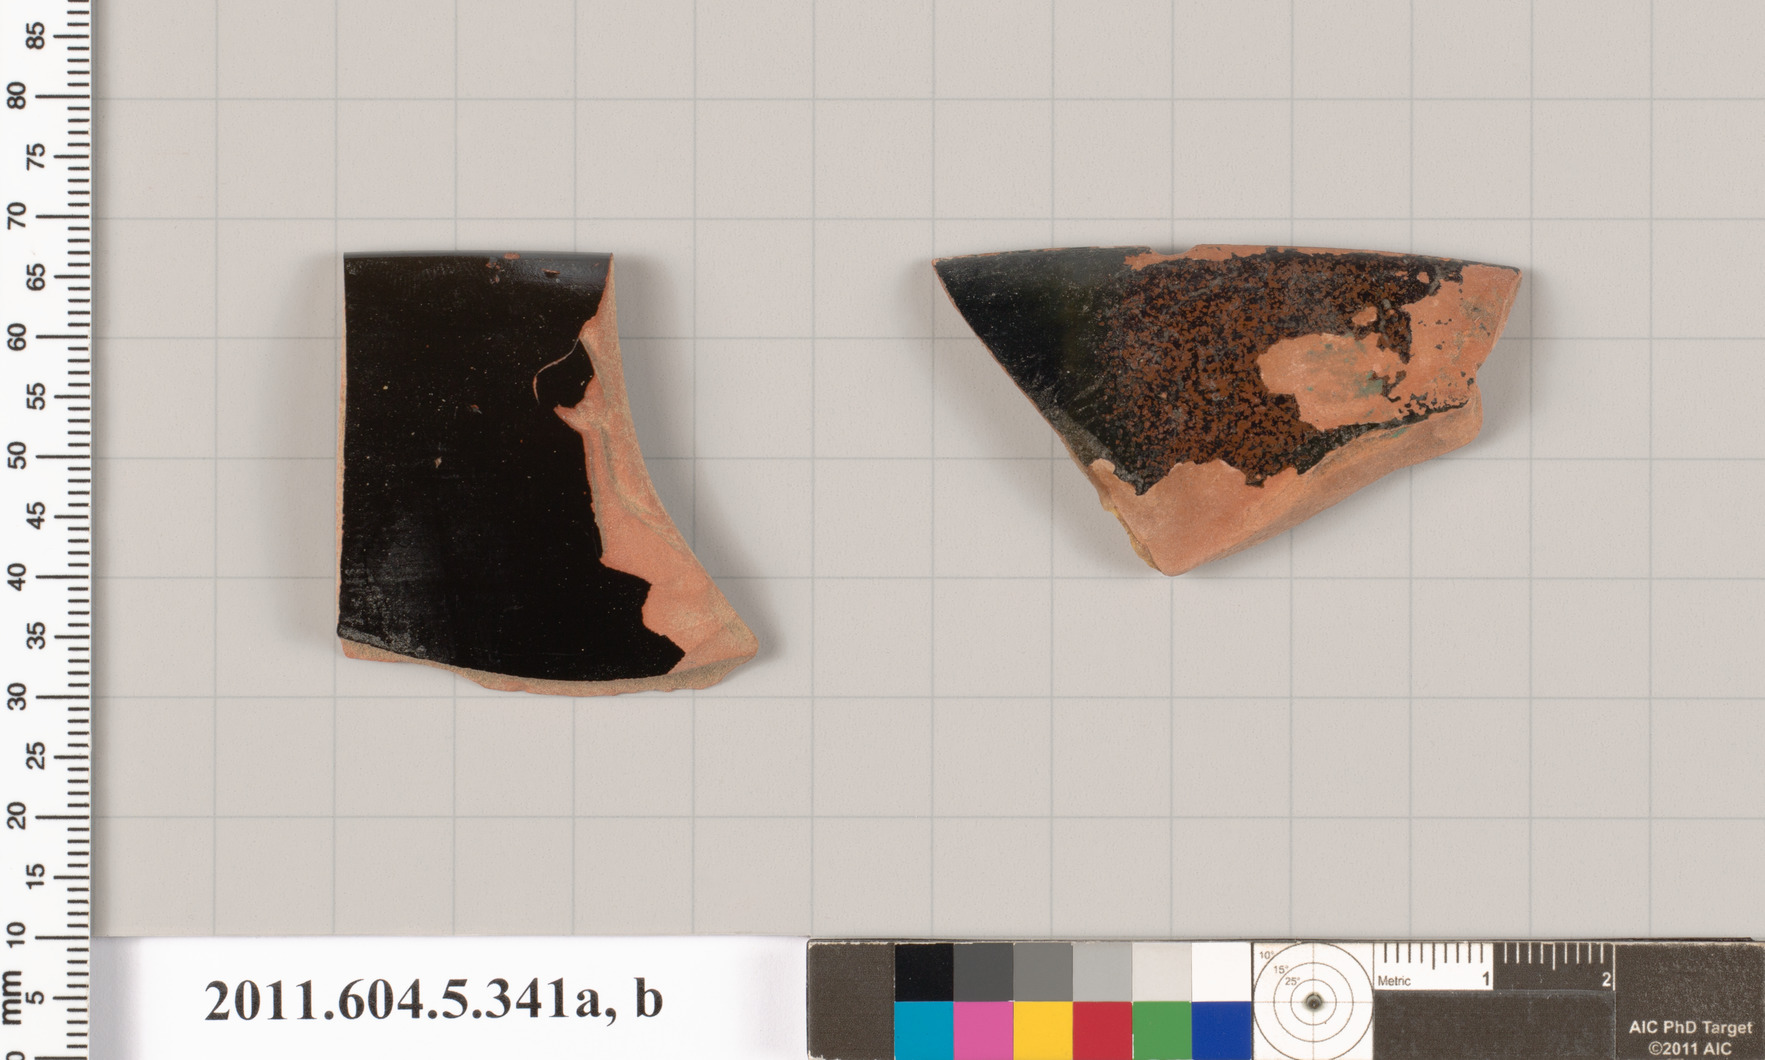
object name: kylix fragment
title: Terracotta rim fragments of kylikes (drinking cups)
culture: greek, attic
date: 600-401 BCE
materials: terracotta